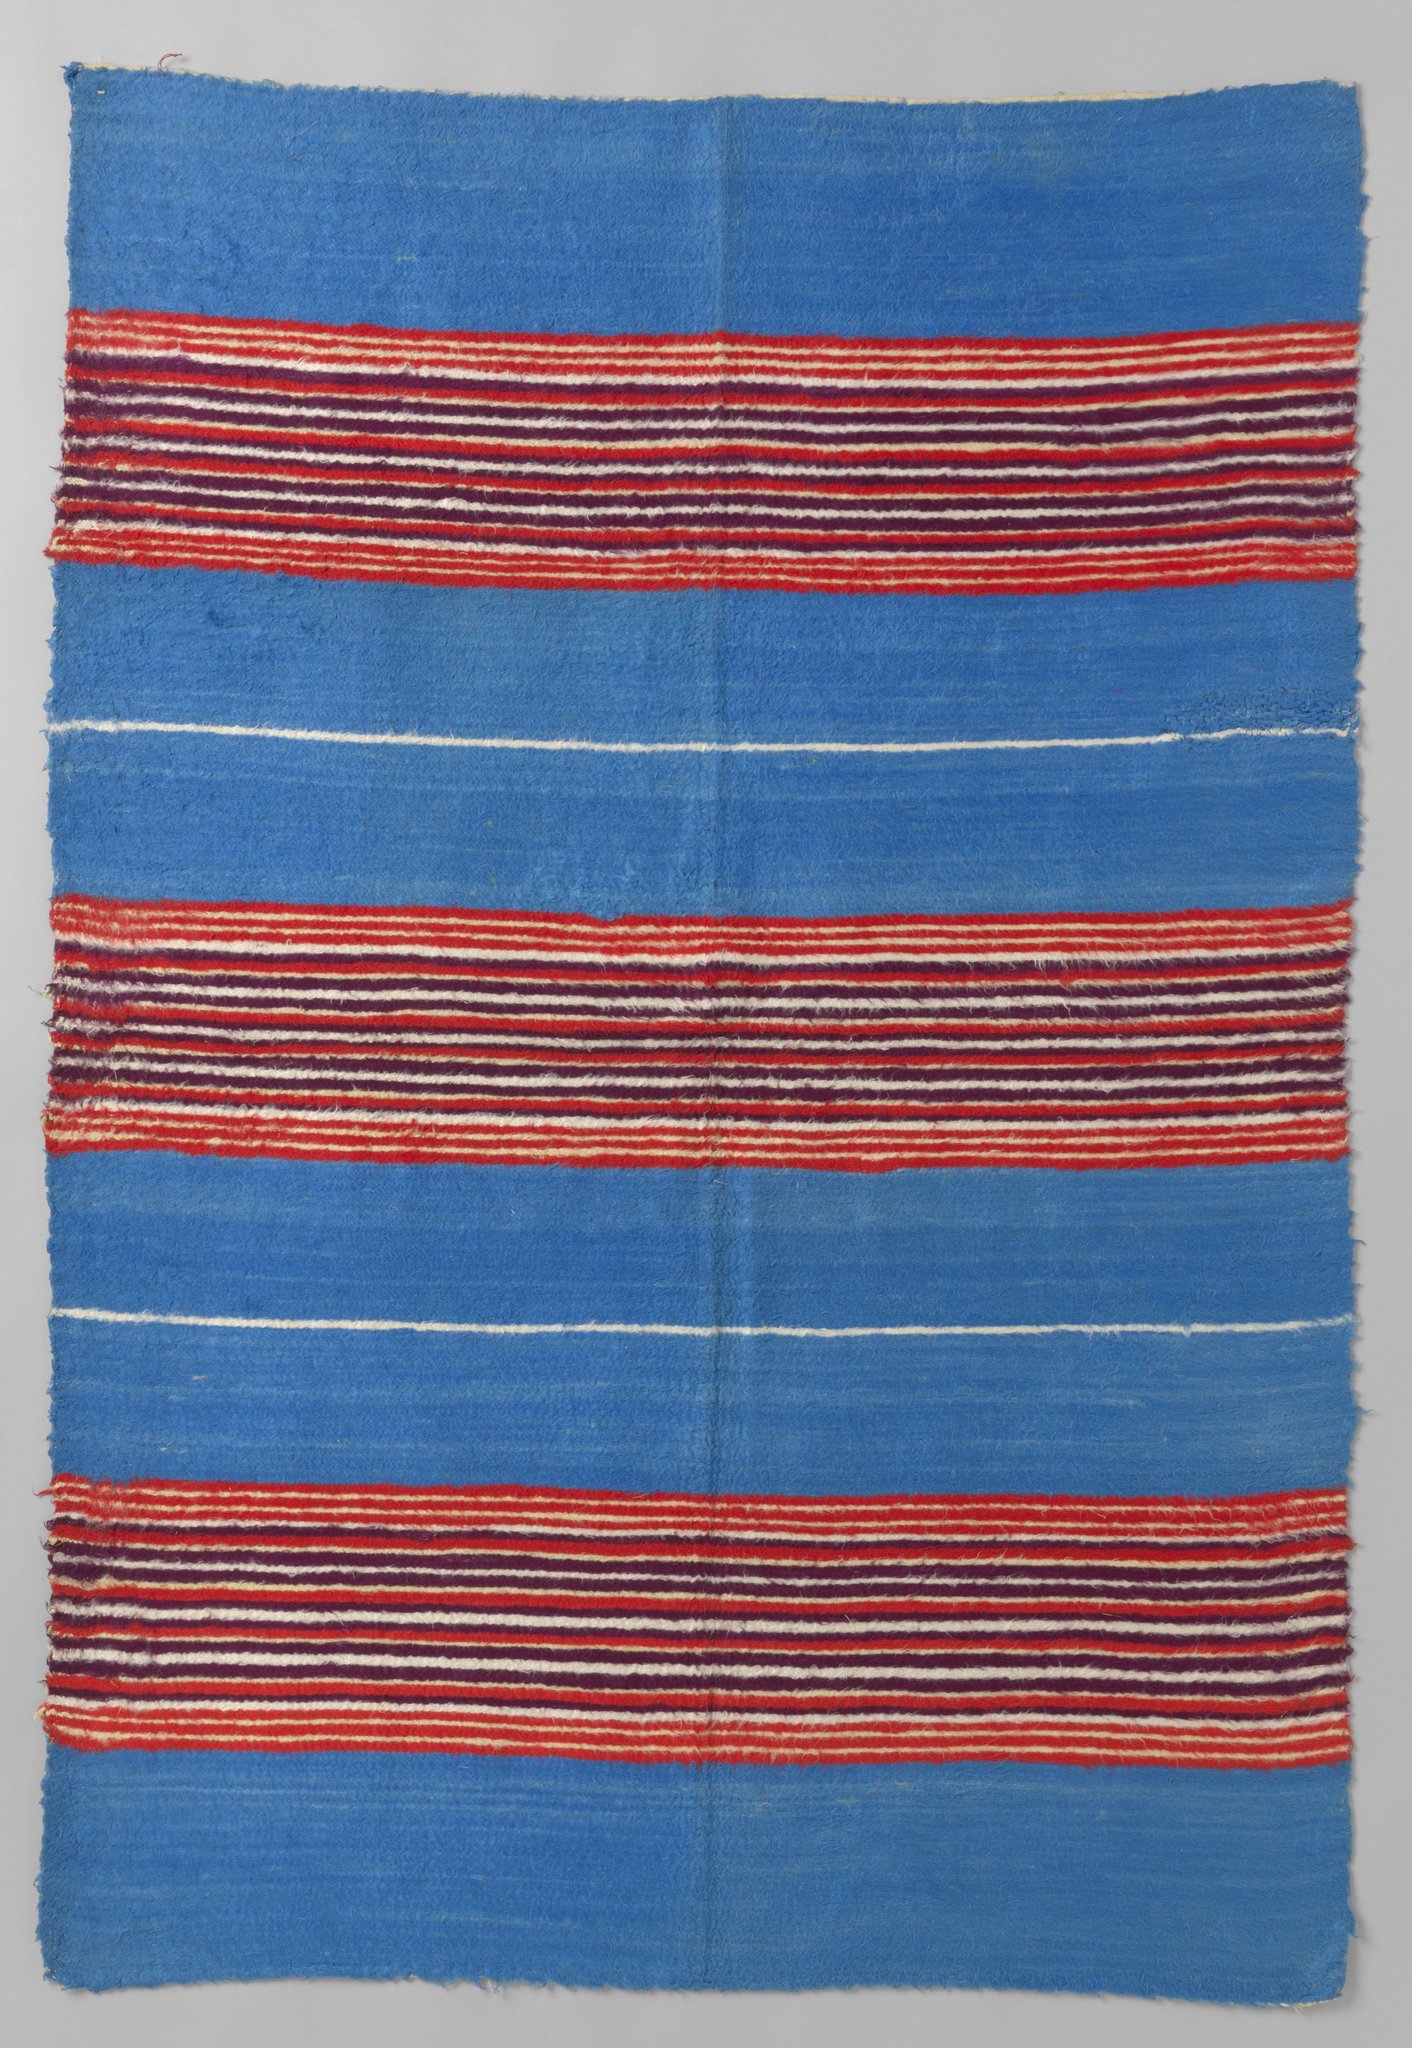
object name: kinderdeken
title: Deken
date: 1860-1870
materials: cotton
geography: netherlands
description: Blauwe kinderdeken met rode, paarse, witte en gele dwarsstrepen.